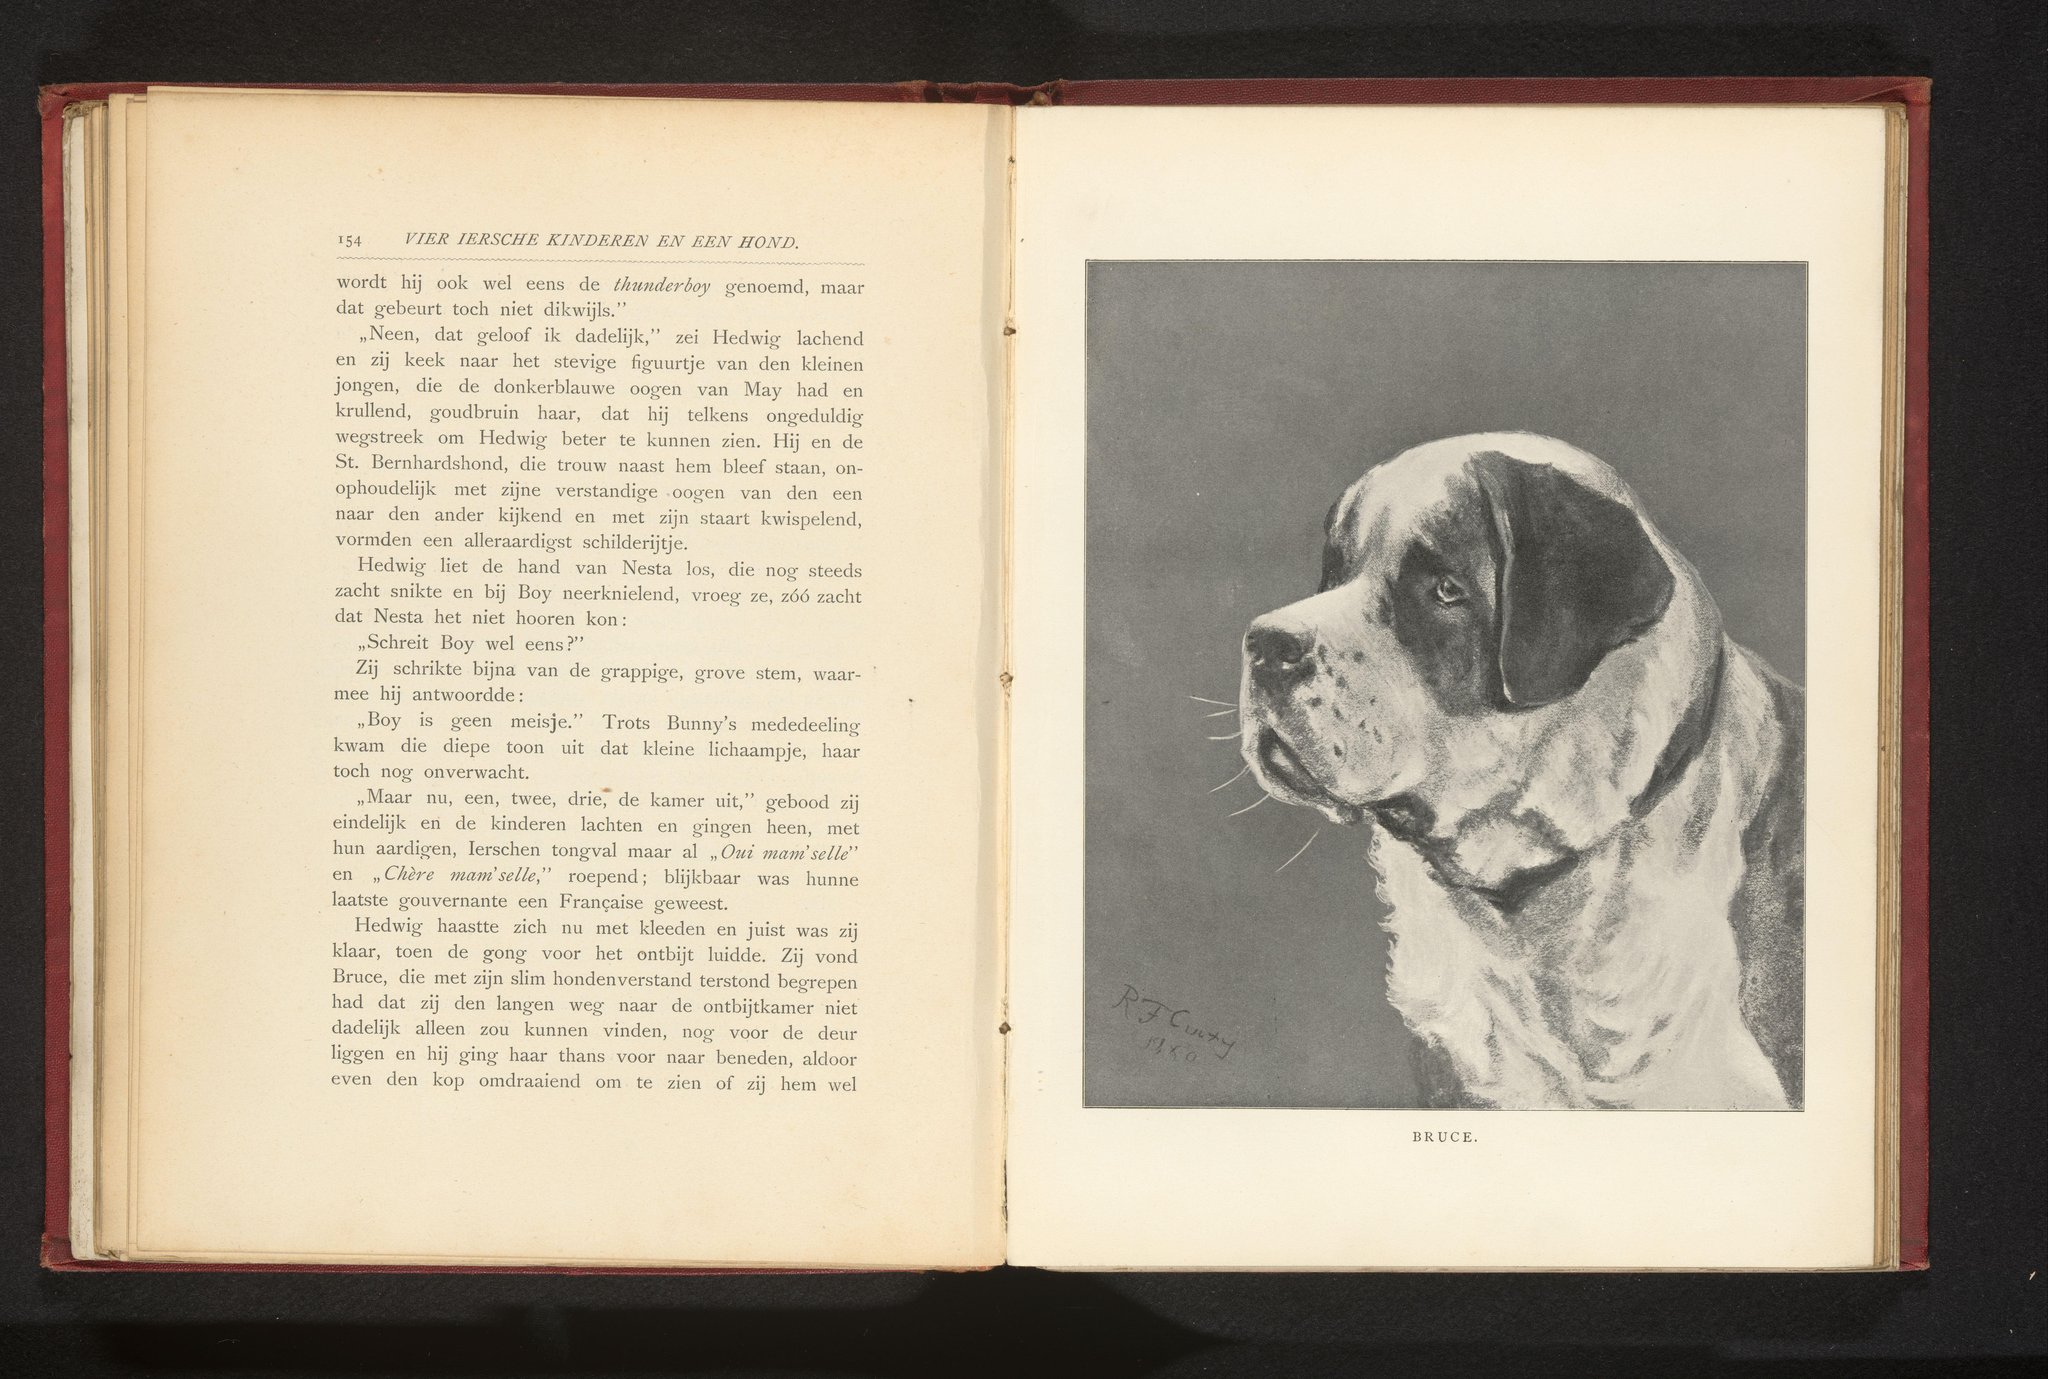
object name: photomechanical print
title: Bruce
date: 1901-1906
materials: paper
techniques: autotype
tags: dog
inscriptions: name: ‘R.F. Cui[.]y/ 19[.]0’